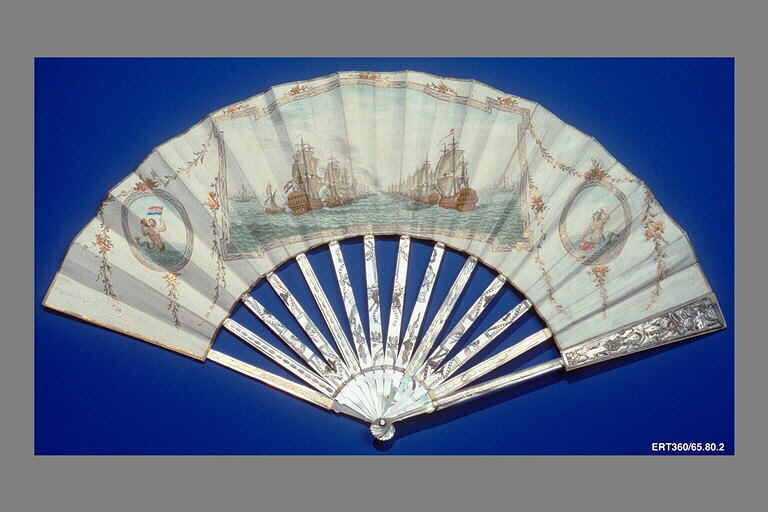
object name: fan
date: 1781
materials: mother of pearl, parchment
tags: ships